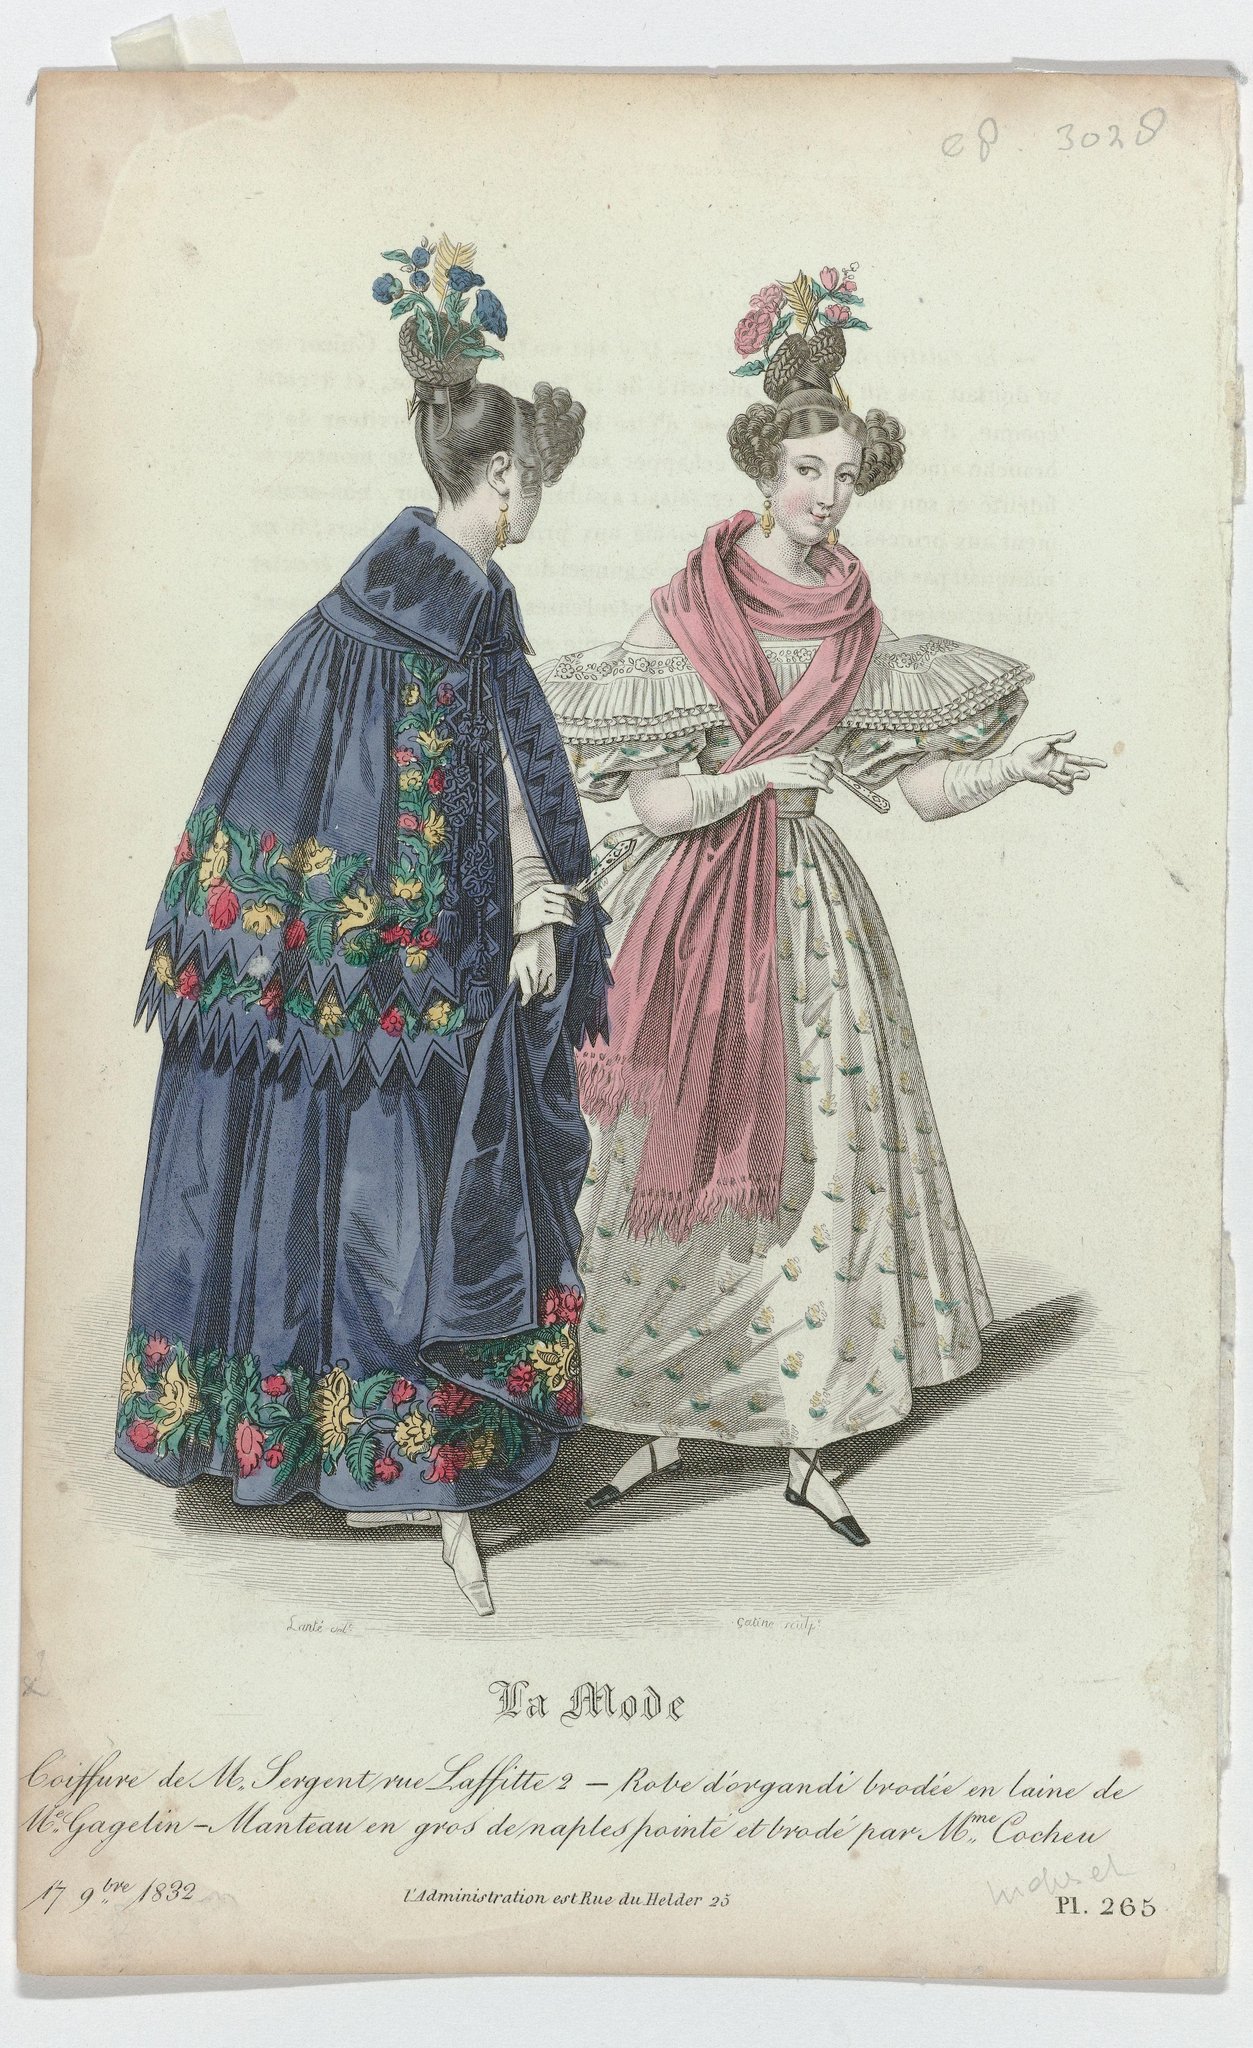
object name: fashion print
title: La Mode, 17 novembre 1832, Pl. 265 : Coiffure de M Sergent (...)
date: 1832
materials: paper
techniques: hand coloring, engraving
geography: paris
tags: gloves, mittens (long gloves) (+ women's clothes), clothing for the upper part of the body (shawl) (+ women's clothes), embroidery (ornamentation) (+ women's clothes), coat (+ women's clothes), head-gear (+ women's clothes), styles of hairdress - aa - ~ women, fashion plates, shoes, sandals (+ women's clothes), dress, gown (+ women's clothes), fan (+ women's clothes)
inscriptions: title: ‘La Mode.’, address: ‘L'Administration est Rue du Helder 25.’, caption: ‘Coiffure de M"Sergent rue Laffitte 2 - Robe d'organdi brodée en laine de M"e Gagelin - Manteau en gros de naples pointe et brodé par M"me Cocheu.’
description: 'Coiffure' (met bloemen en pijl) van M. Sergent. Japon van organdie, geborduurd met wol, van Gagelin. Mantel van 'gros de naples pointé' en borduurwerk van Cocheu. Accessoires: oorbellen, sjaal afgezet met franjes, lange handschoenen, waaier, platte schoenen met gekruiste banden en vierkante neuzen. Prent uit het modetijdschrift La Mode (1829-1855).